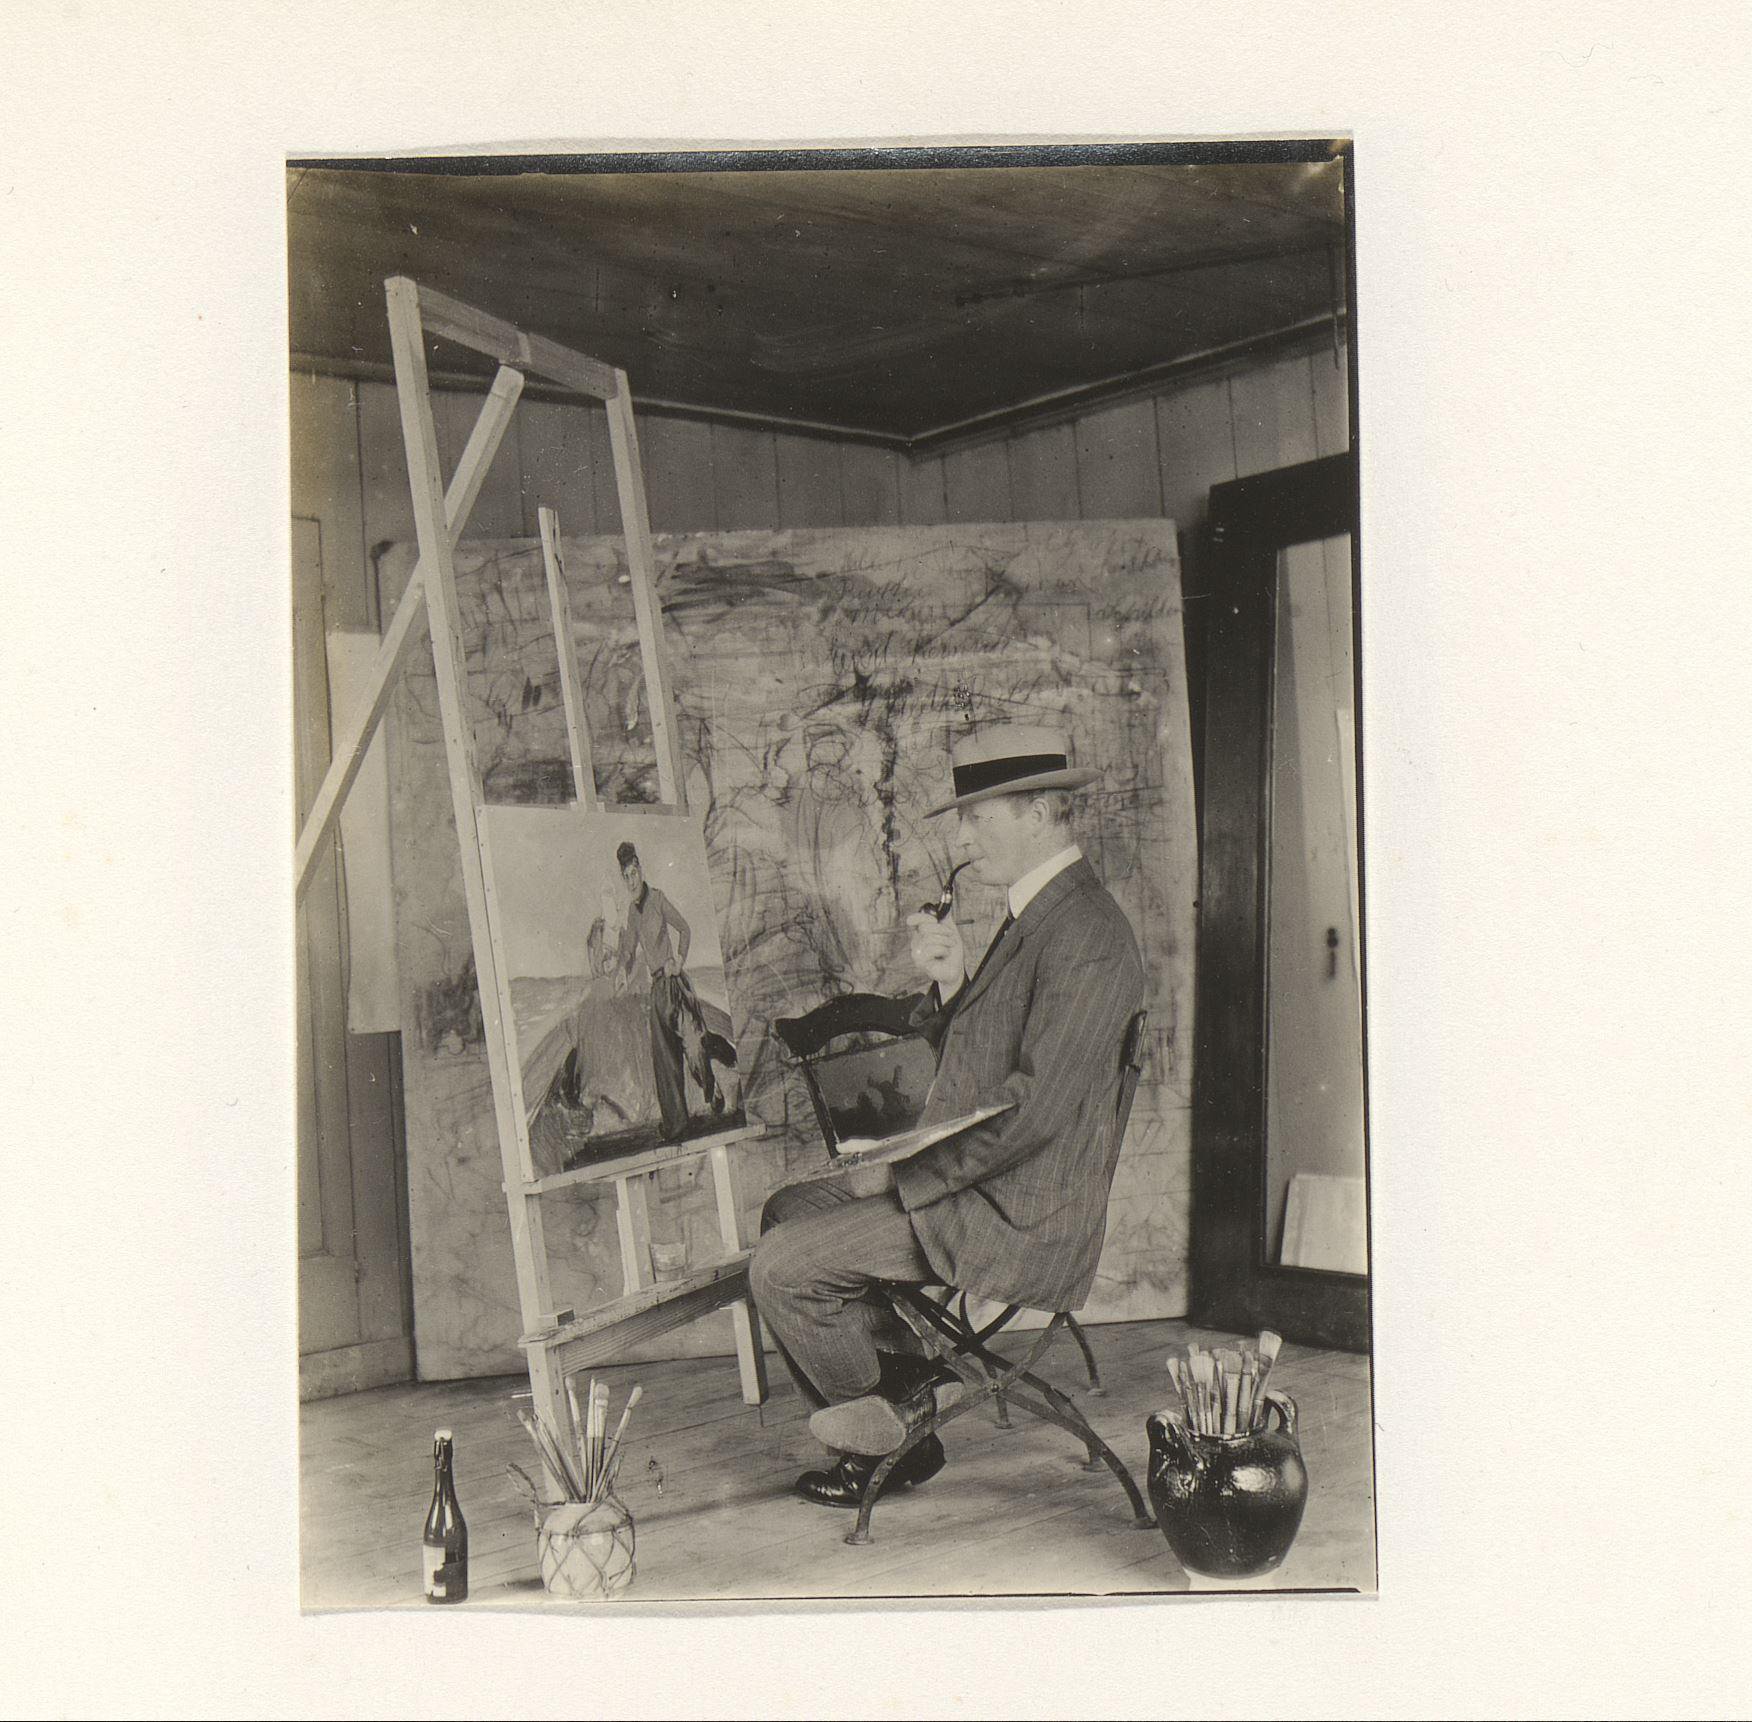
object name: photograph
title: Man in een schildersatelier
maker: george hidderley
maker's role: fotograaf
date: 1900-1910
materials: paper, photographic support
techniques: gelatin silver print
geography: volendam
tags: adult man, historical persons, workshop, studio ~ painter